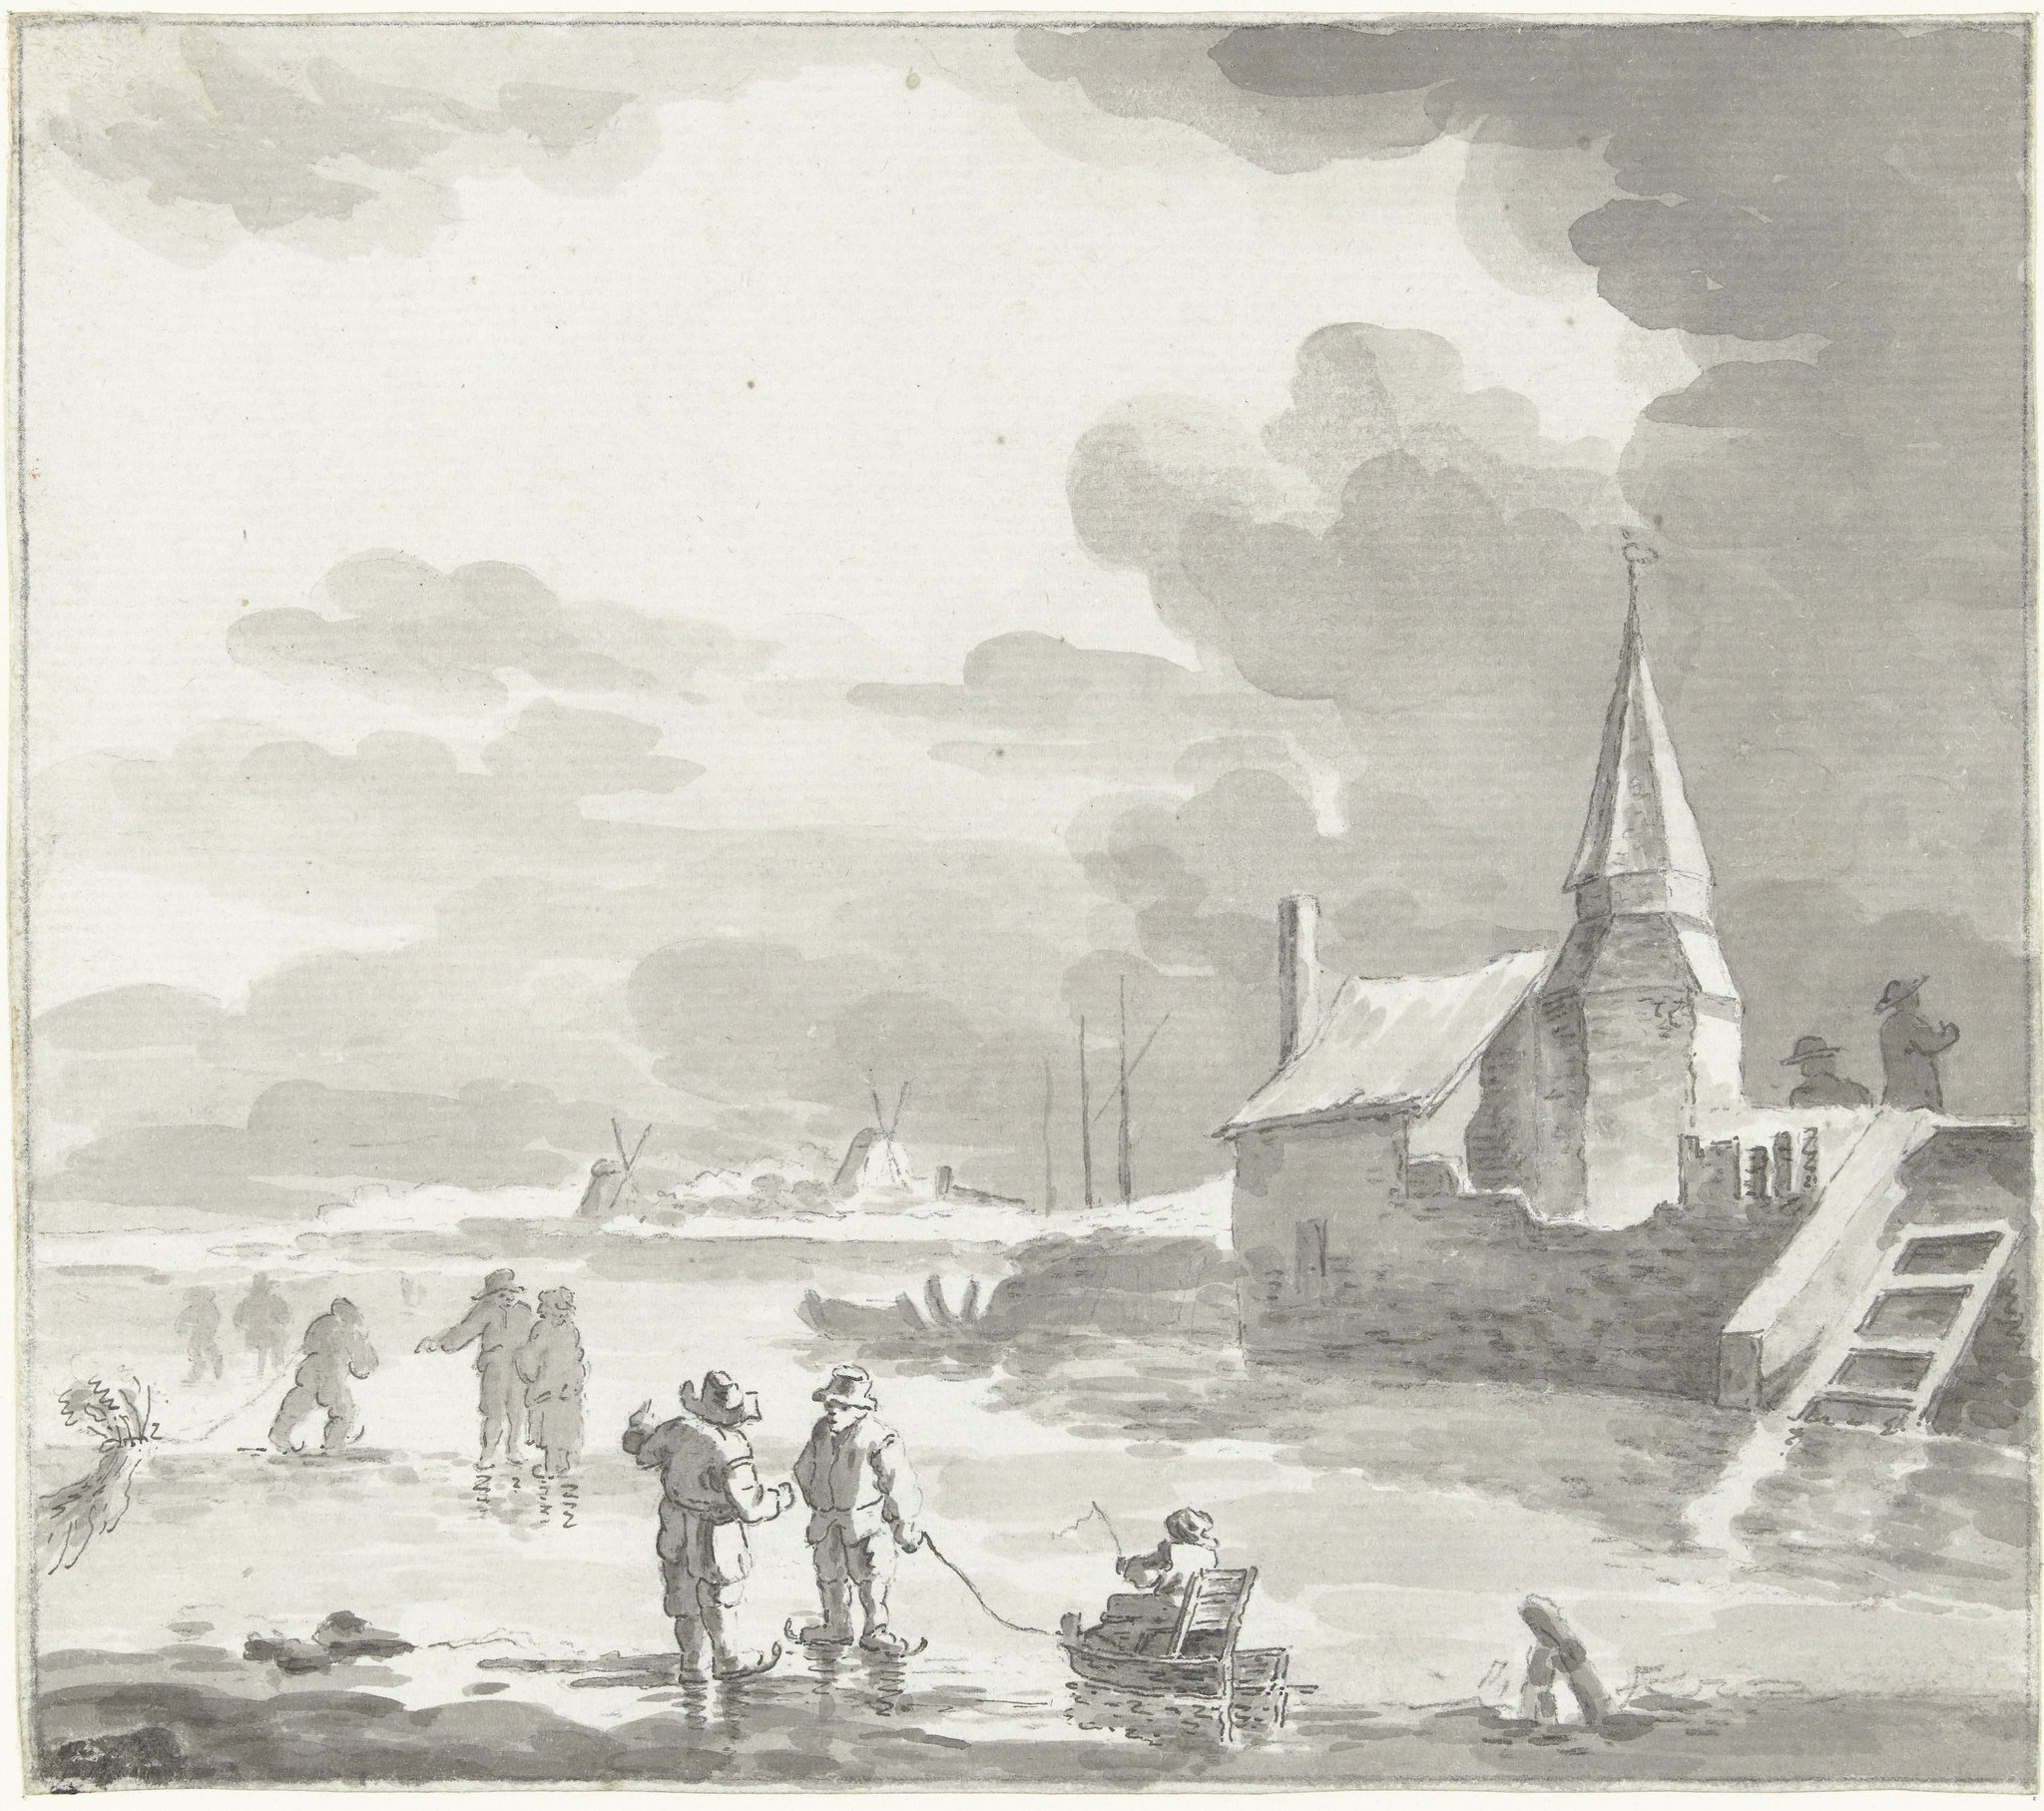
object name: drawing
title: Winterlandschap met schaatsenrijders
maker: jacob ernst marcus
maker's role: draughtsman, print maker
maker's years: 1774-1826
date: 1789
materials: ink, paper, pencil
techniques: brush, pen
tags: winter sports, ice ~ freezing weather